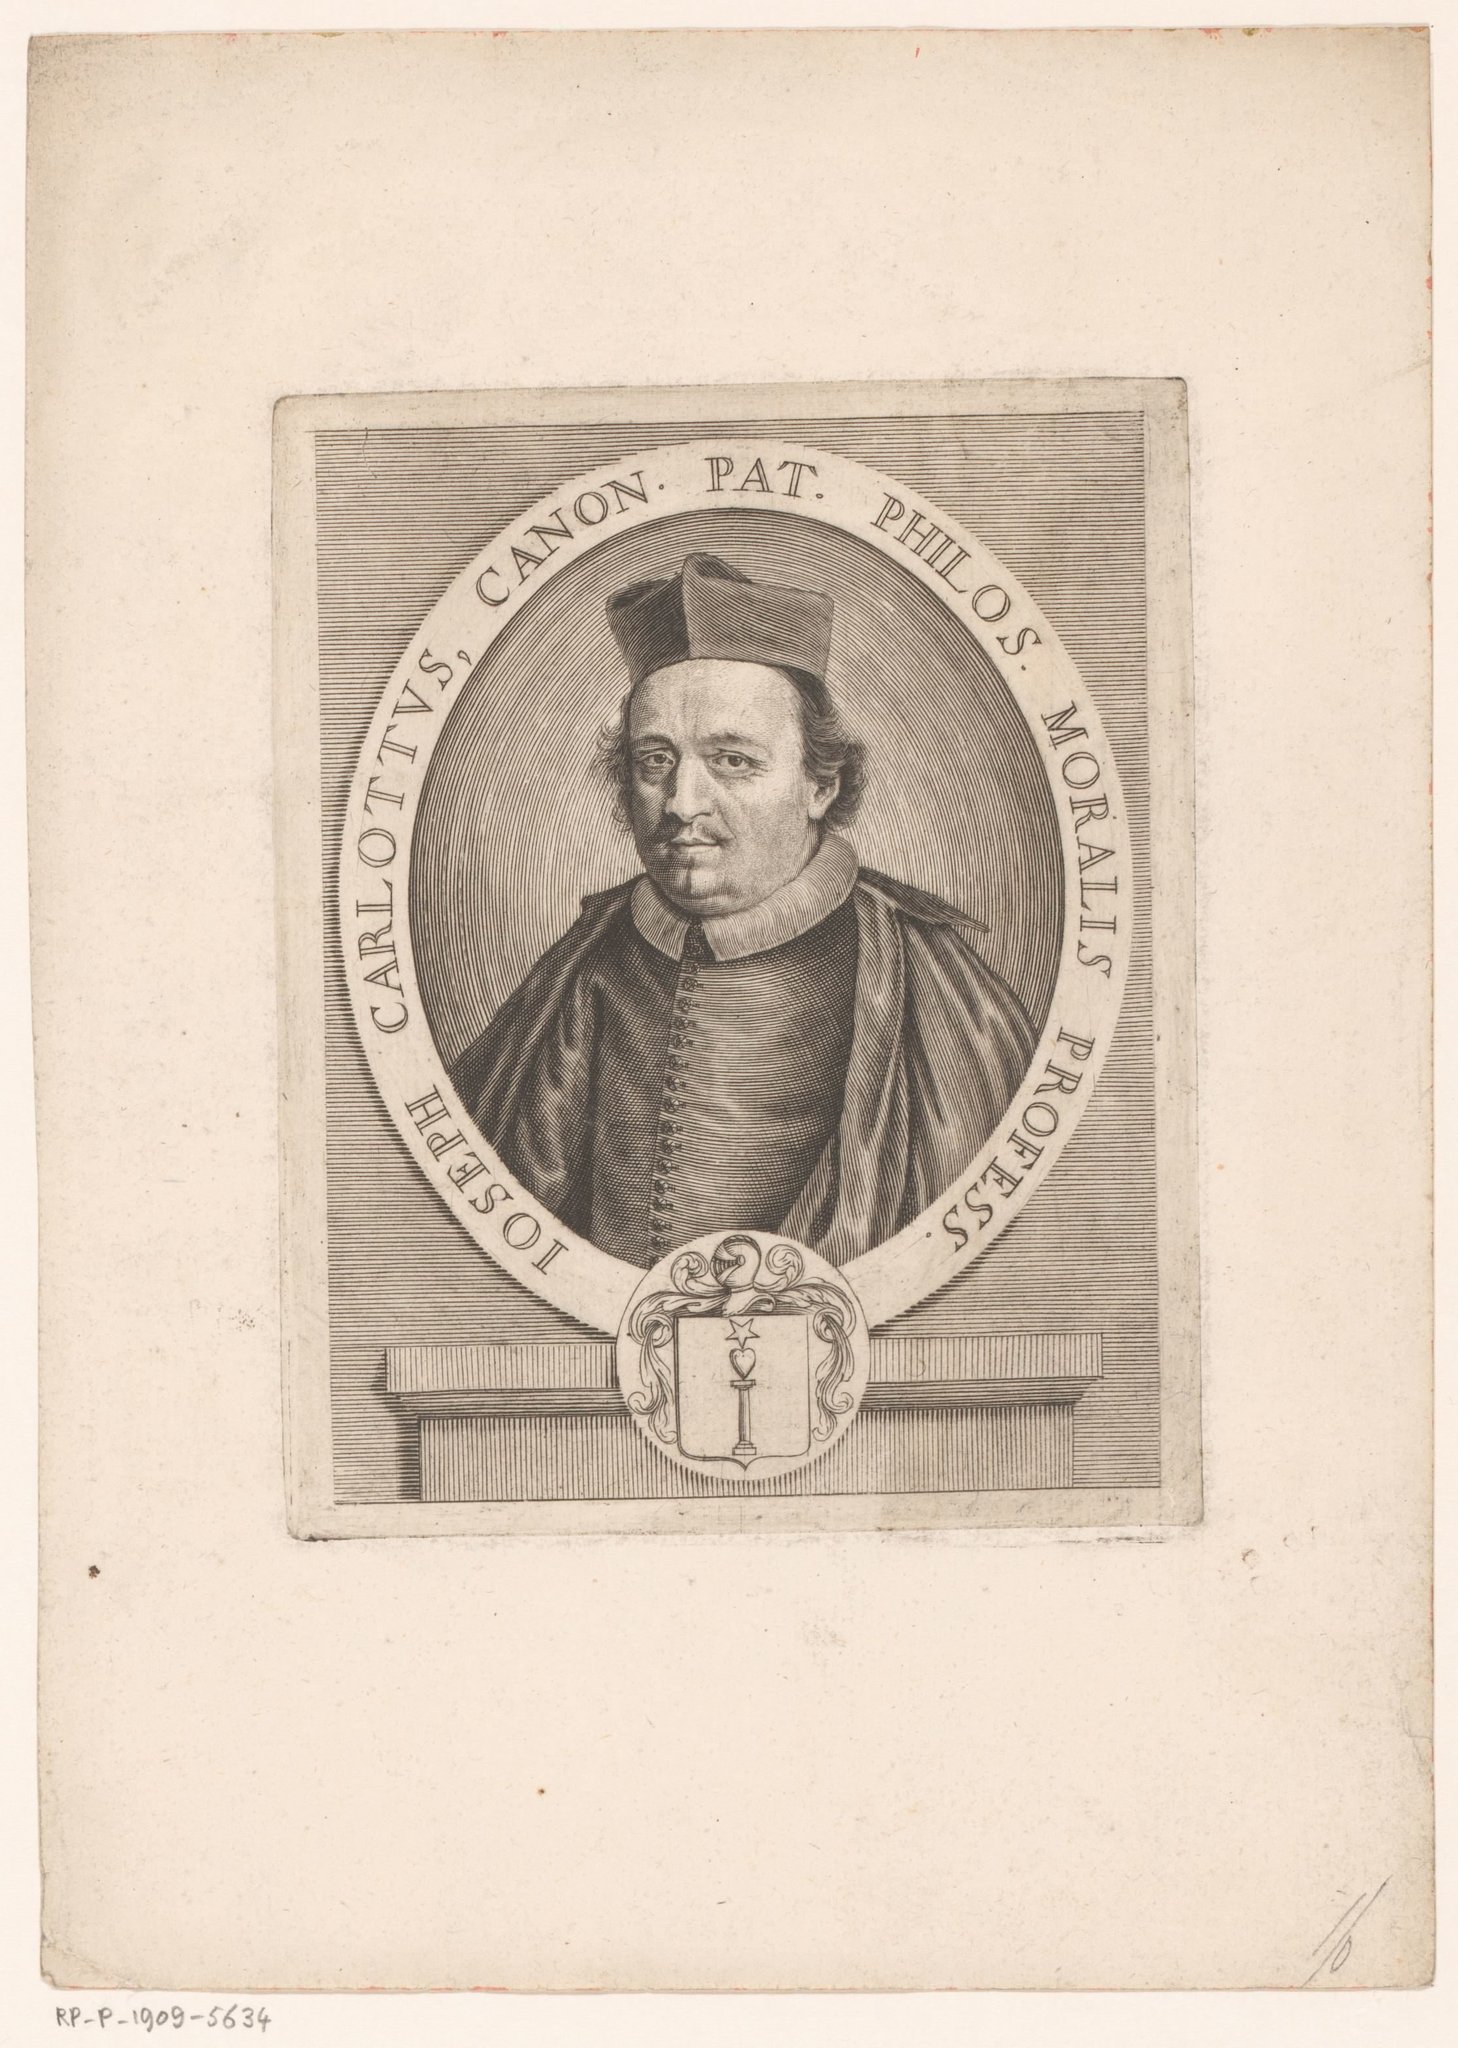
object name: book illustration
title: Portret van Joseph Carlottus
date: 1682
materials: paper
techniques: engraving, etching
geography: padua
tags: historical persons, professor, armorial bearing, heraldry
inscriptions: collector's mark: Lugt 2228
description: Prent uit: Patin, Charles. Lyceum Patavinum: sive icones et vitae professorum. Padua: Frambotti, Petri Mariae, 1682.